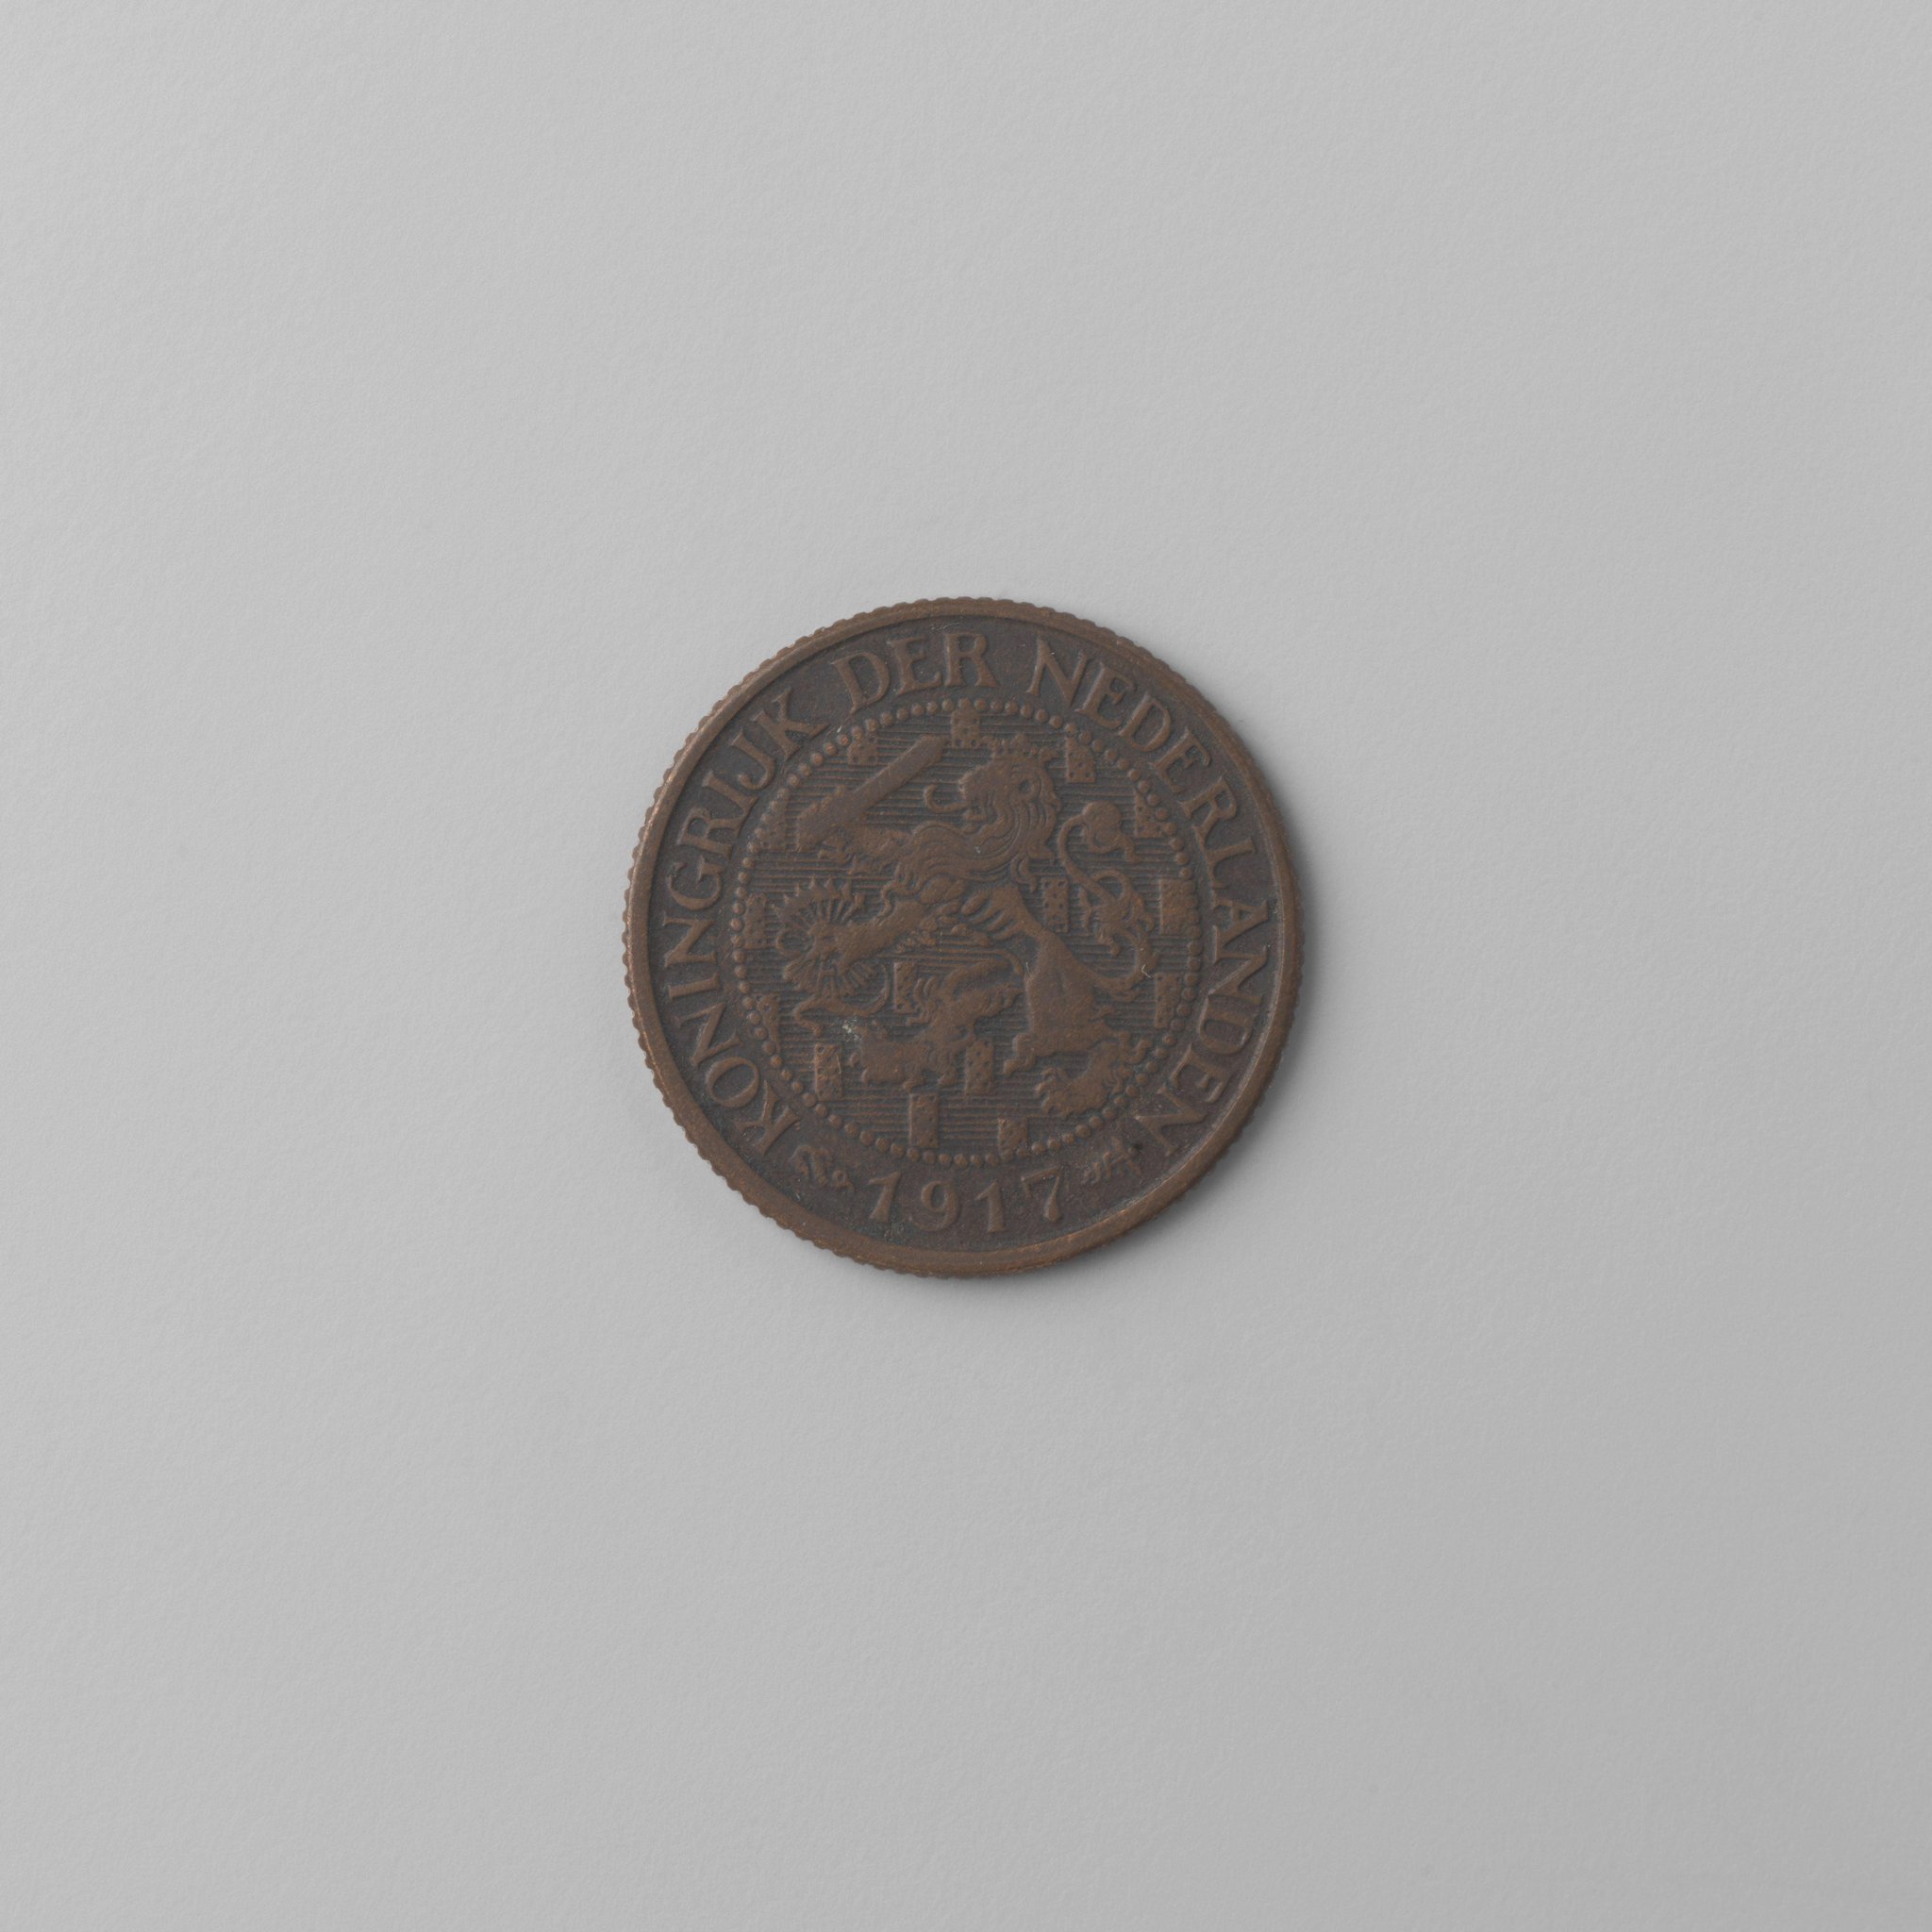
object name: cent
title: Nederlandse cent,1917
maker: wilhelmina of the netherlands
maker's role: print maker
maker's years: 1880-1962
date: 1917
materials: bronze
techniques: striking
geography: utrecht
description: Bronzen munt. Voorzijde: in een veld rijkswapen. Jaartal onderaan in omschrift. Keerzijde: binnen twee samengebonden oranjetakken waarde-aanduiding 1 cent. Kartelrand.